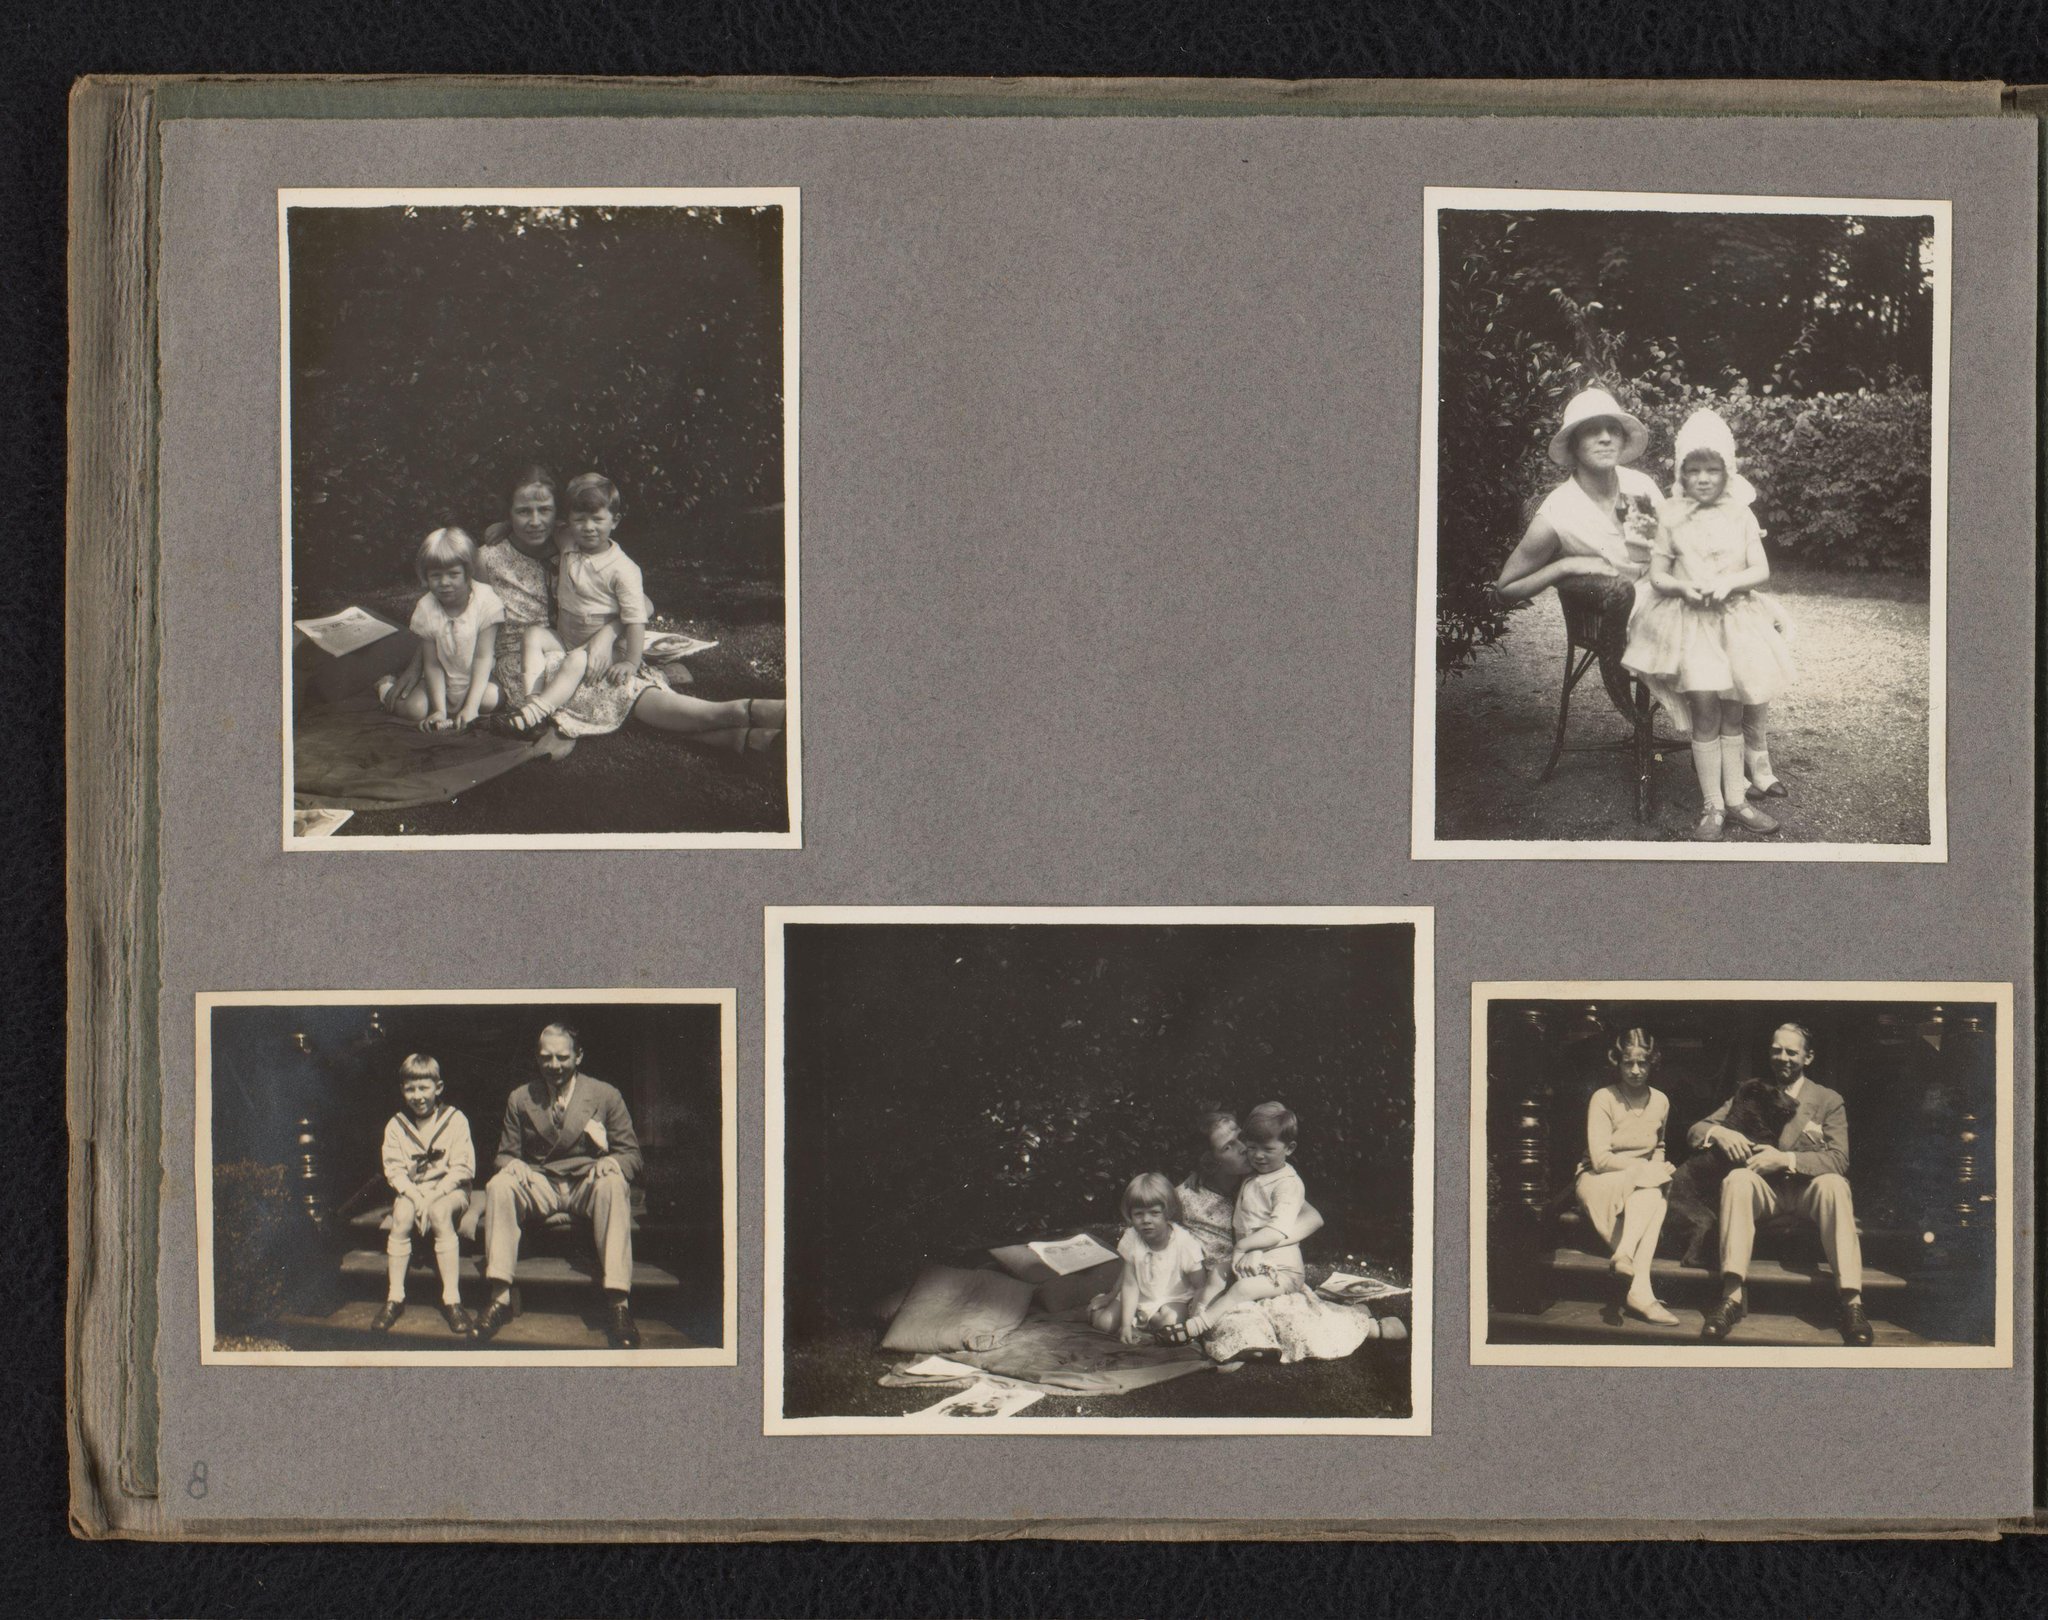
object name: album leaf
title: Vijf foto's van verschillende leden van familie Onnen-Van den Berg in een tuin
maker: Anonymous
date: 1920-1930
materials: paper, cardboard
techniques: gelatin silver print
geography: hilversum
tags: garden, historical persons, family life, open-air recreation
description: Deze foto's maken deel uit van een album.